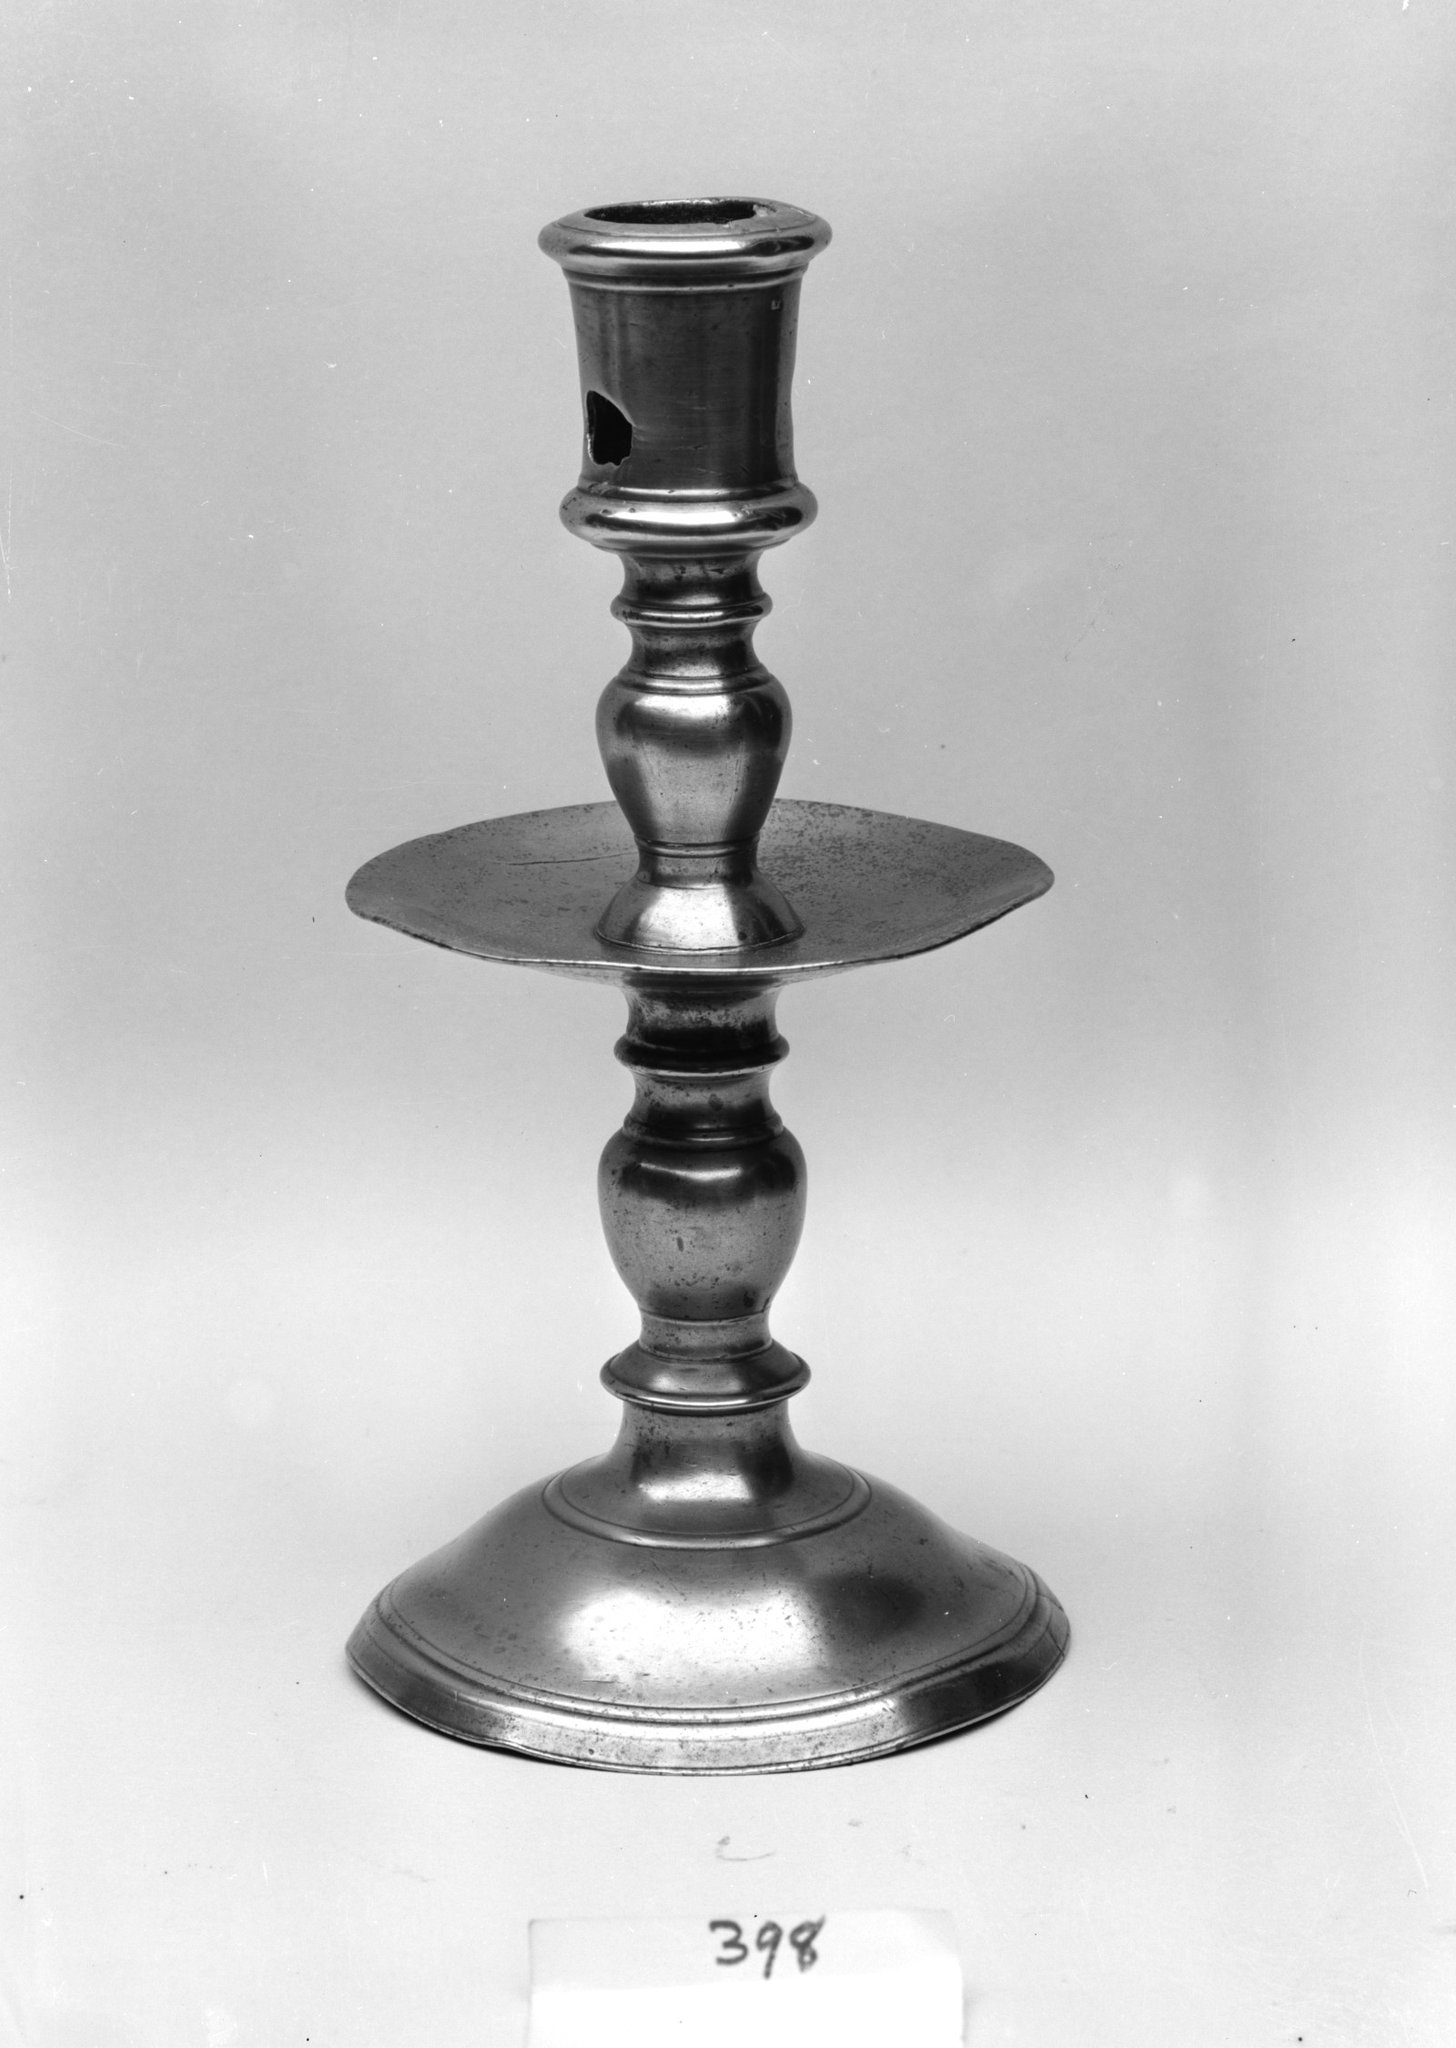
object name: candlestick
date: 1600-1700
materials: brass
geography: netherlands